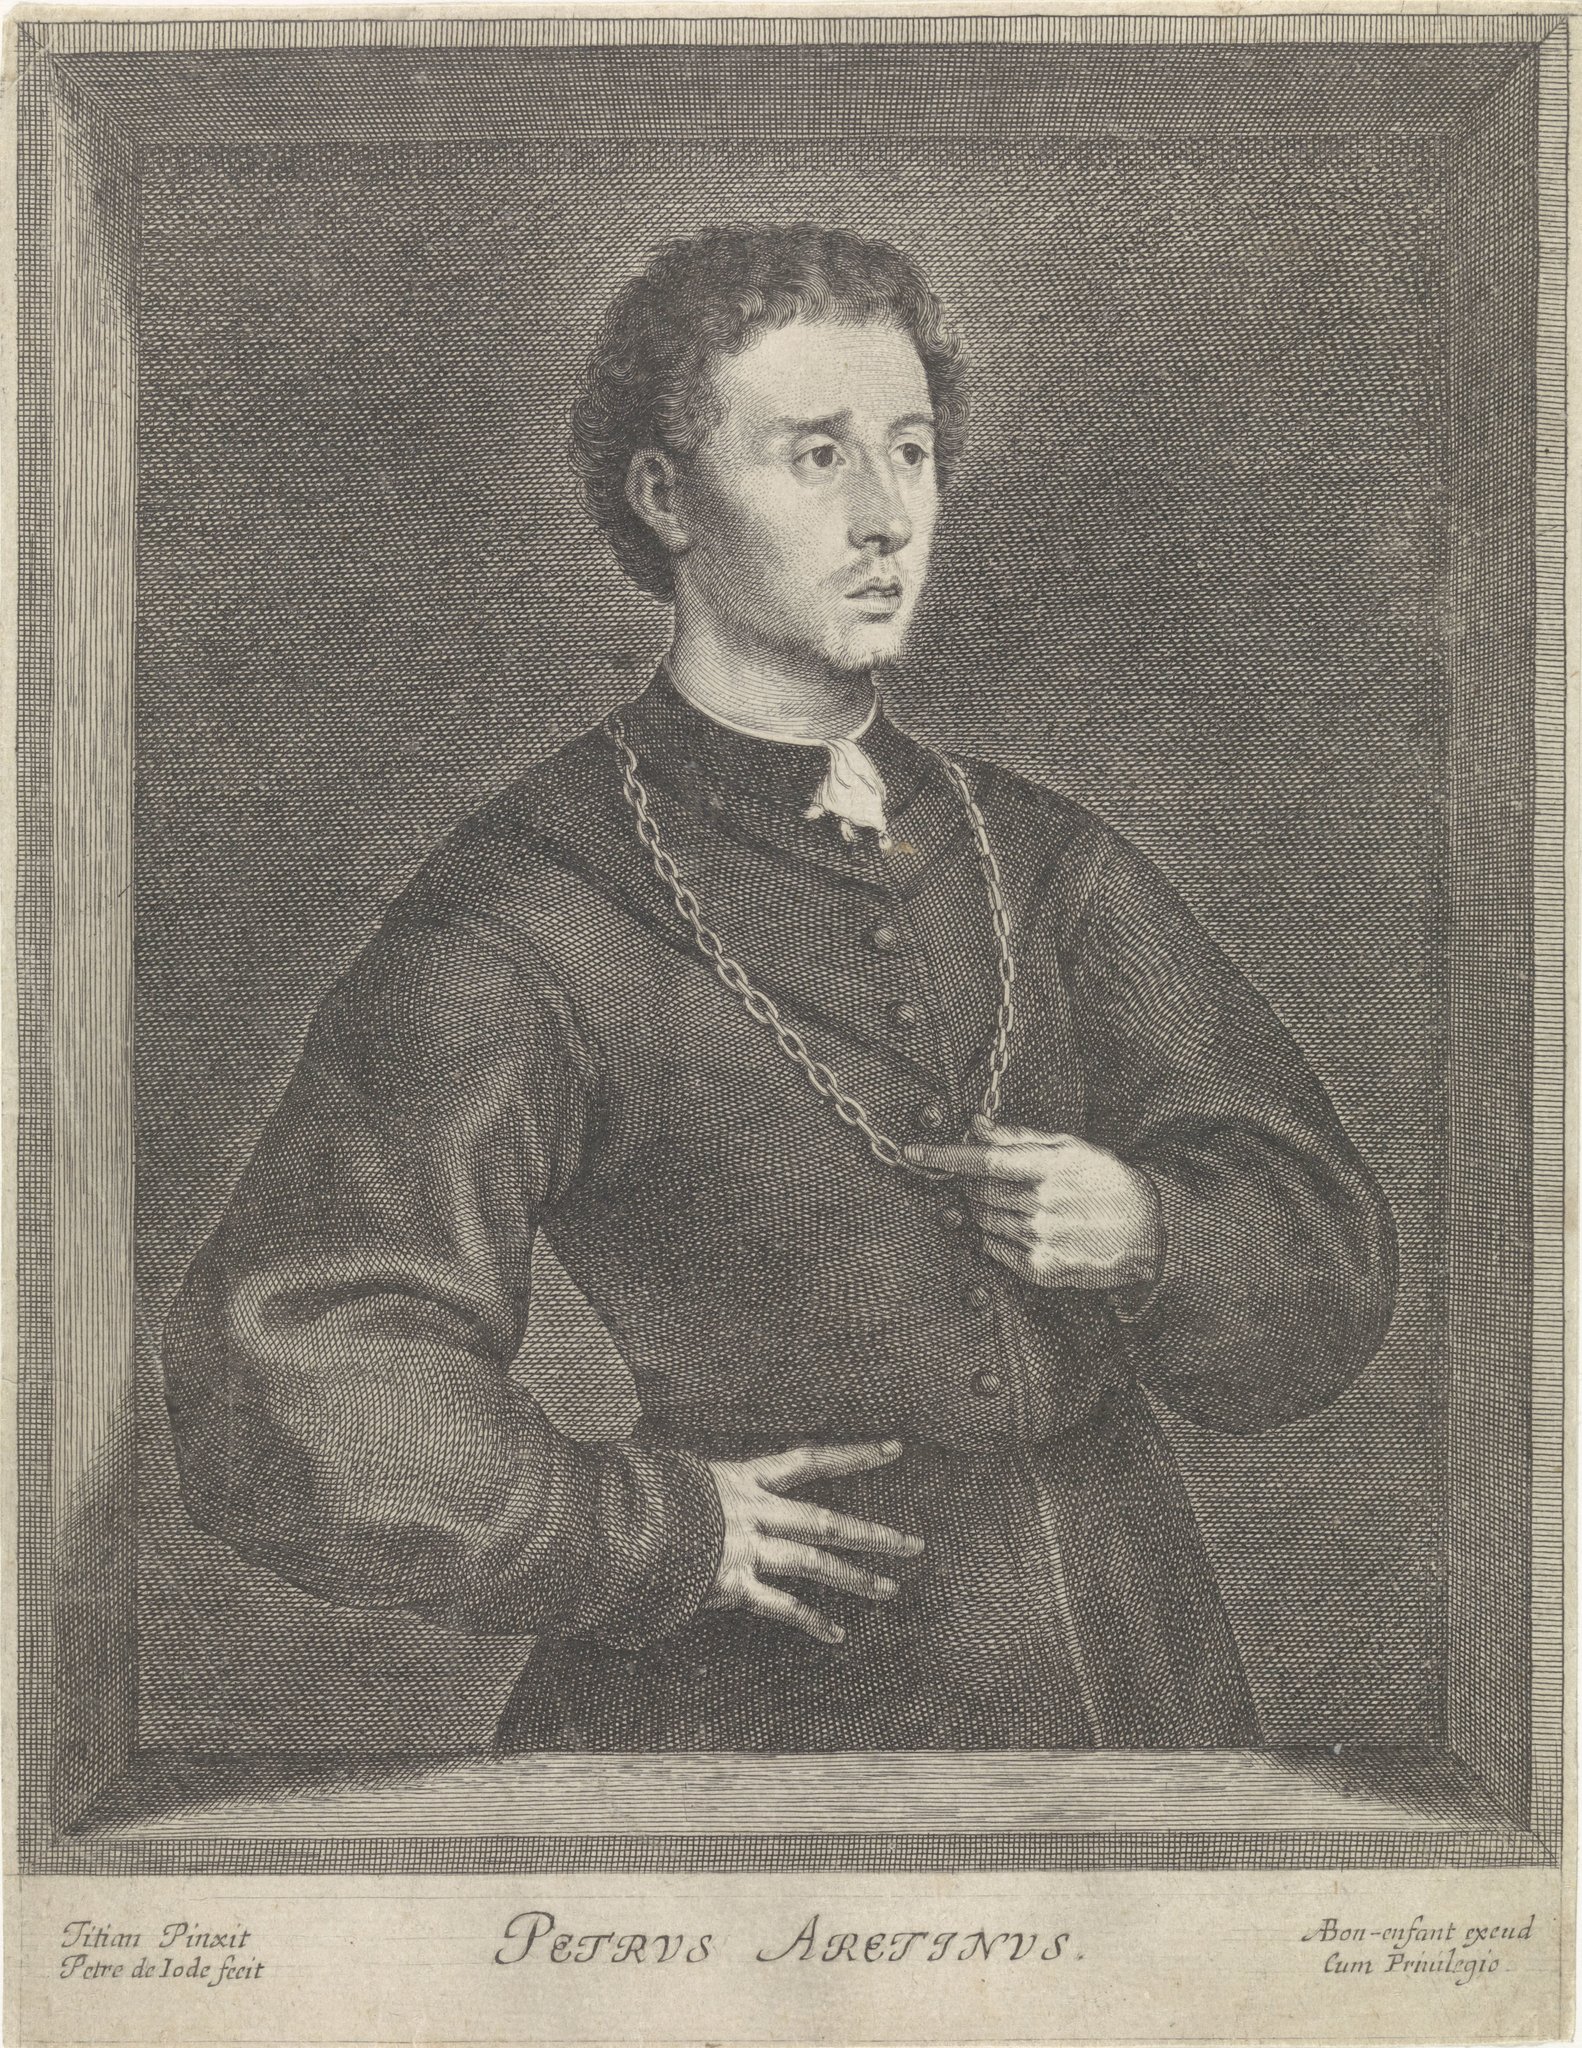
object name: print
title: Portret van Pietro Aretino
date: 1628-1670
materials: paper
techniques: engraving, etching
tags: venice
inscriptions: collector's mark: Lugt 2228, collector's mark: ‘G. Storck a Milano 1798 In.N. 6109’ Lugt 2318, collector's mark: ‘V C’ Lugt 2507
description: Portret van de Italiaanse dichter Pietro Aretino, ten halven lijve. In de marge de naam van de geportretteerde.